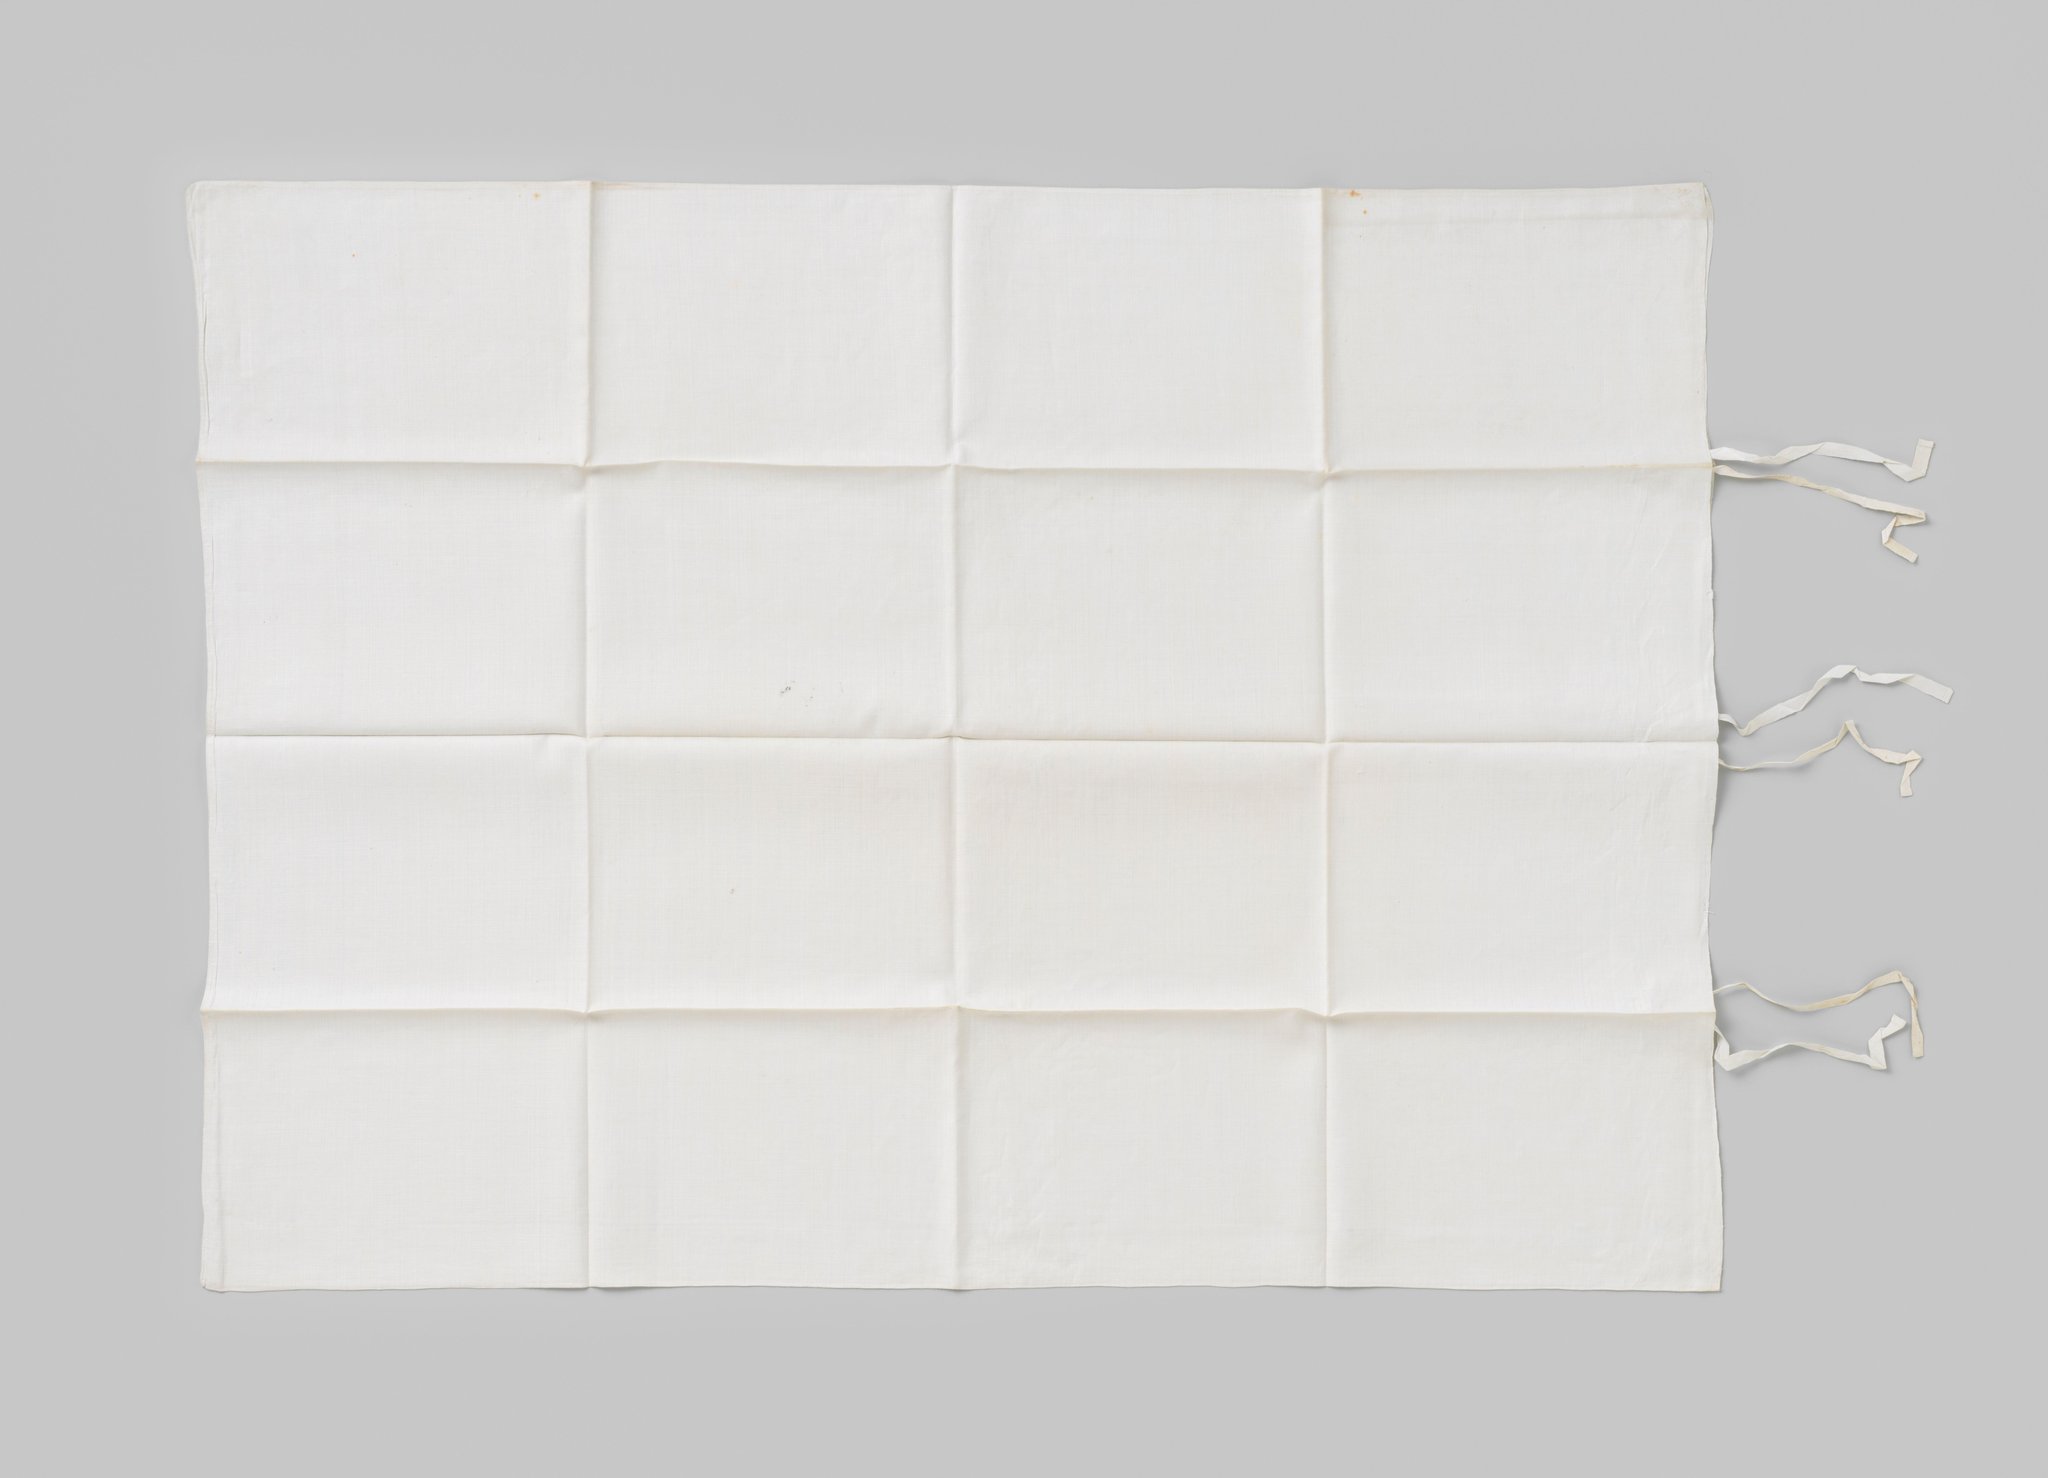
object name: sloop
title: Sloop van wit linnen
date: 1725-1767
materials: linen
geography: northern netherlands